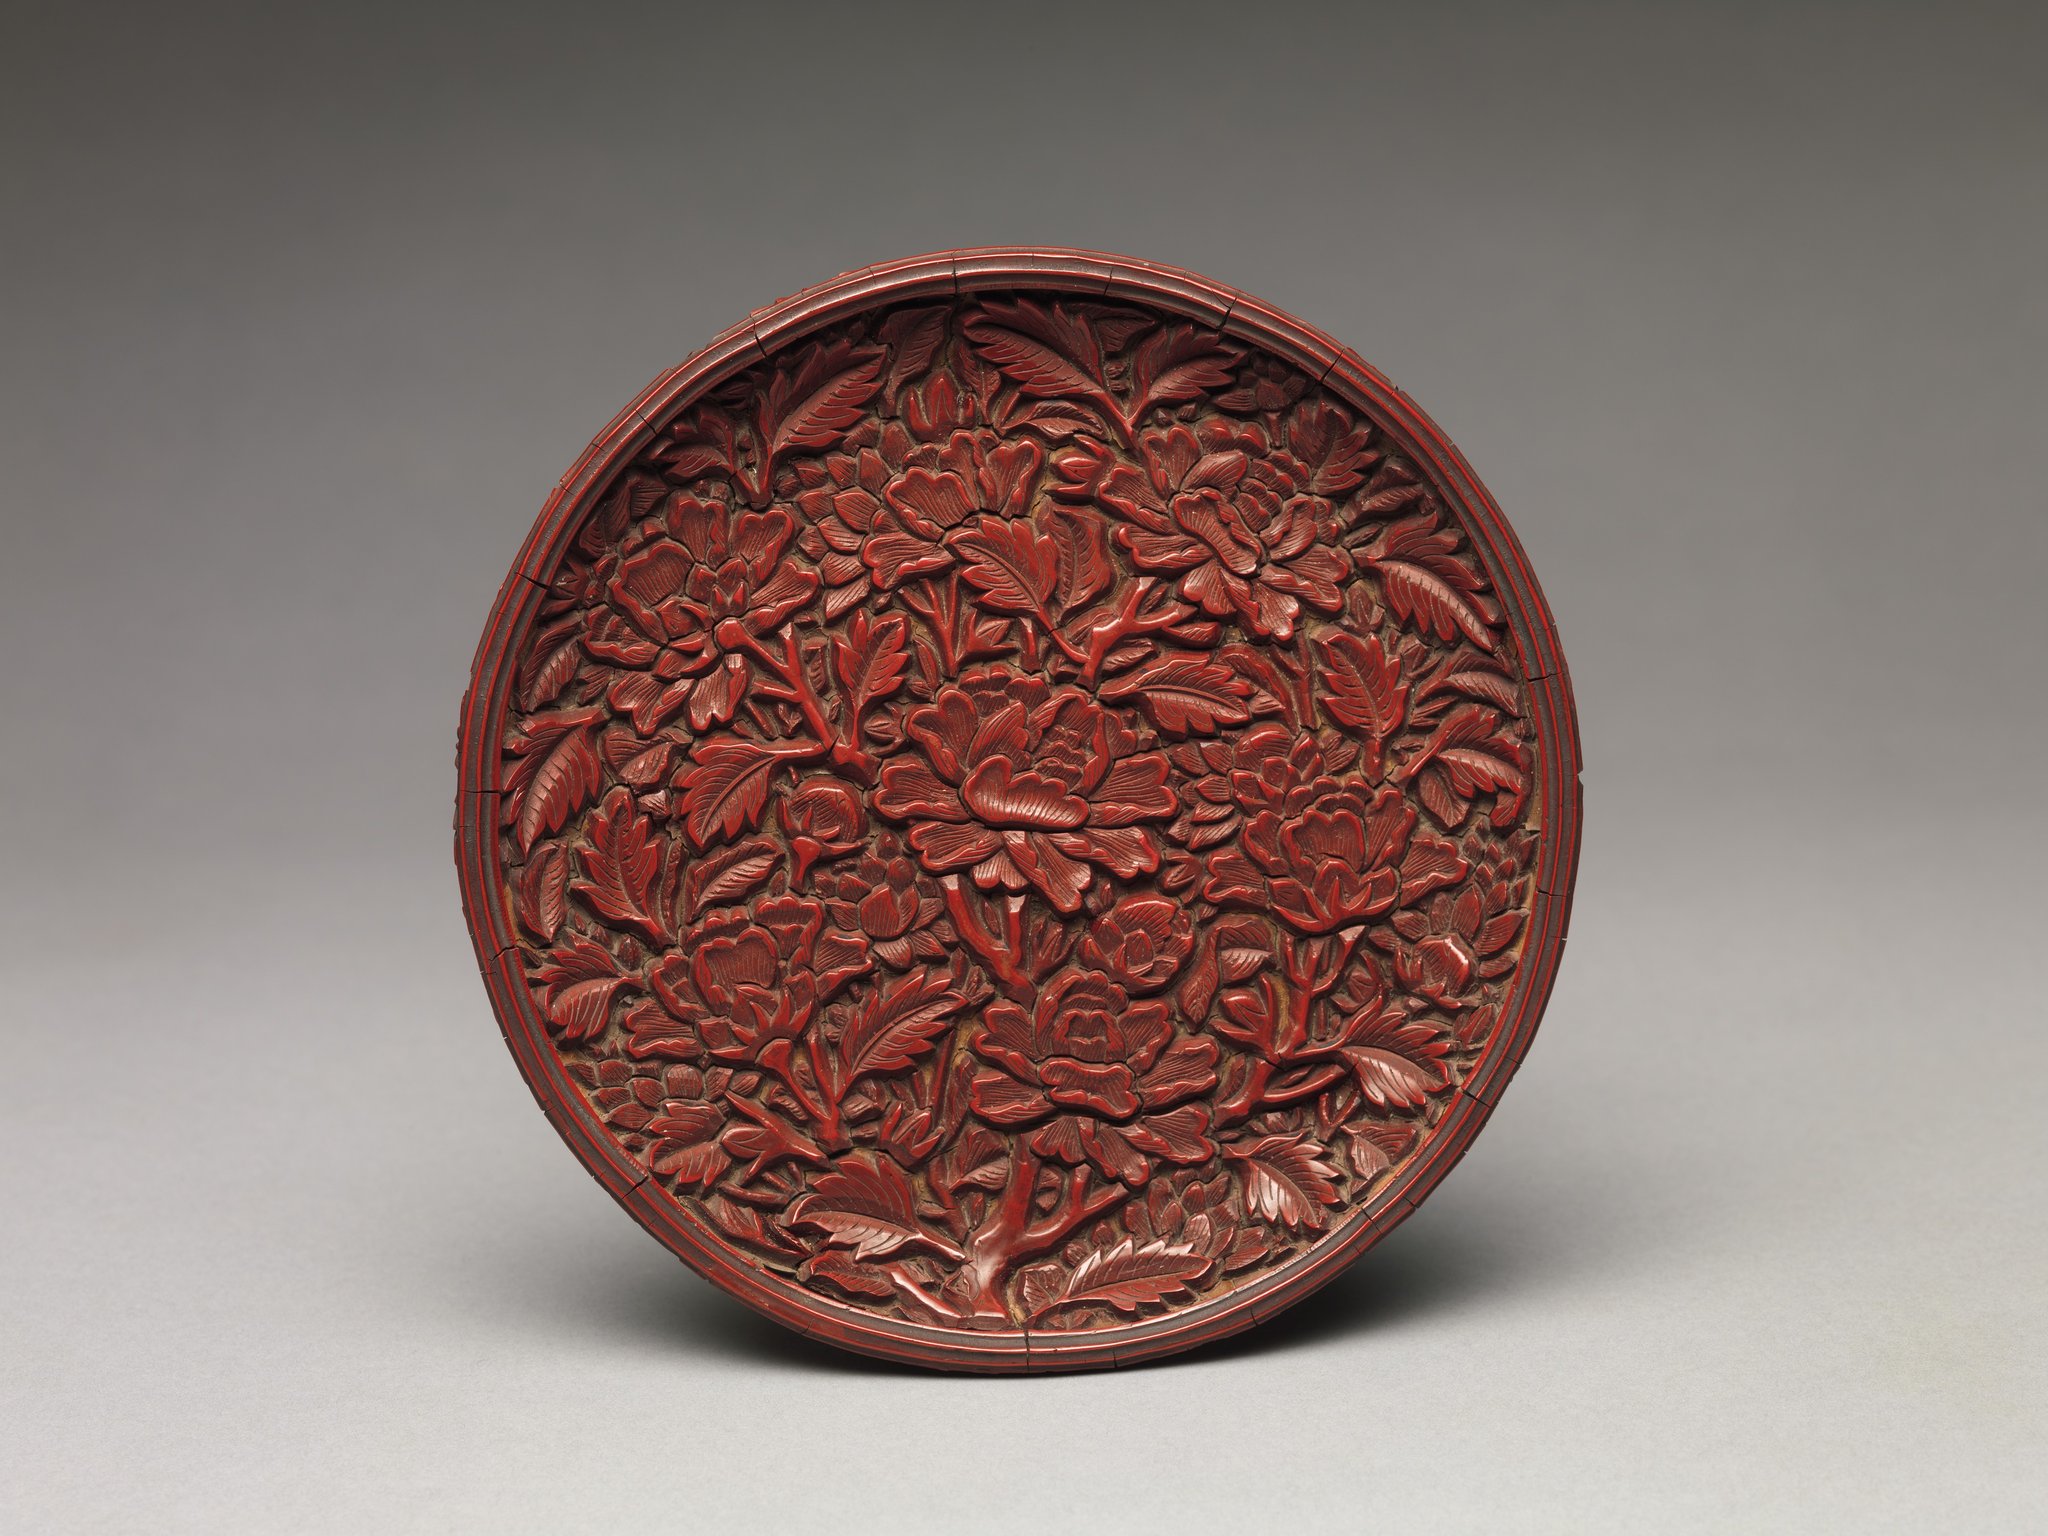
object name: dish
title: Pair of dishes with peonies and lotuses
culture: chinese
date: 1367-1500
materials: lacquer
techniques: carving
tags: flowers,leaves